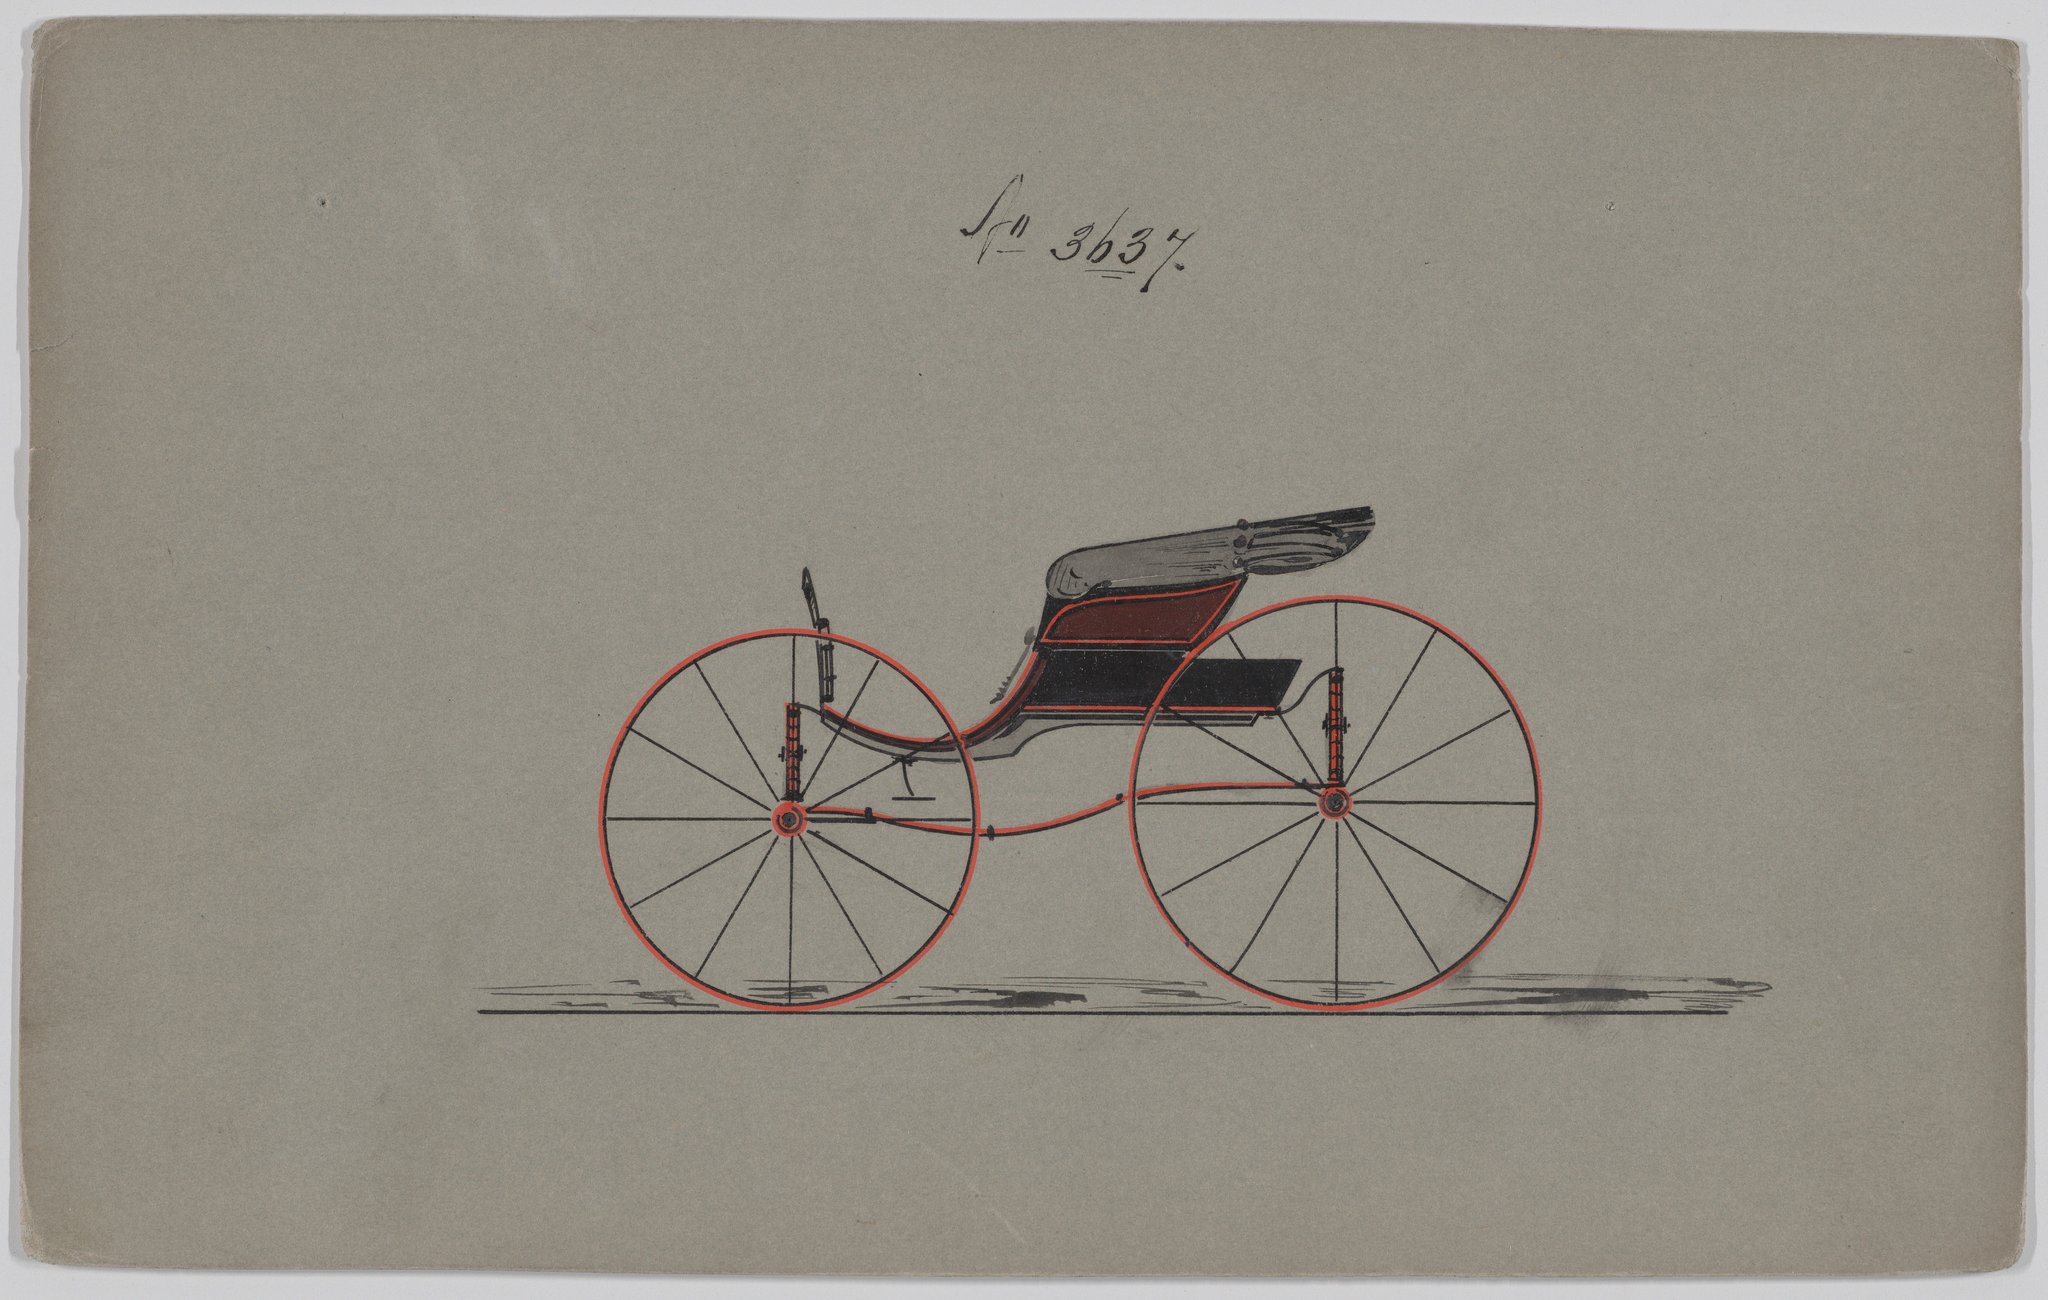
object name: drawing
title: Design for Pony Phaeton, no. 3637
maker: brewster & co.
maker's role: manufacturer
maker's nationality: american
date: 1880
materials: gouache, gum arabic, ink, watercolor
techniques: pen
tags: carriages